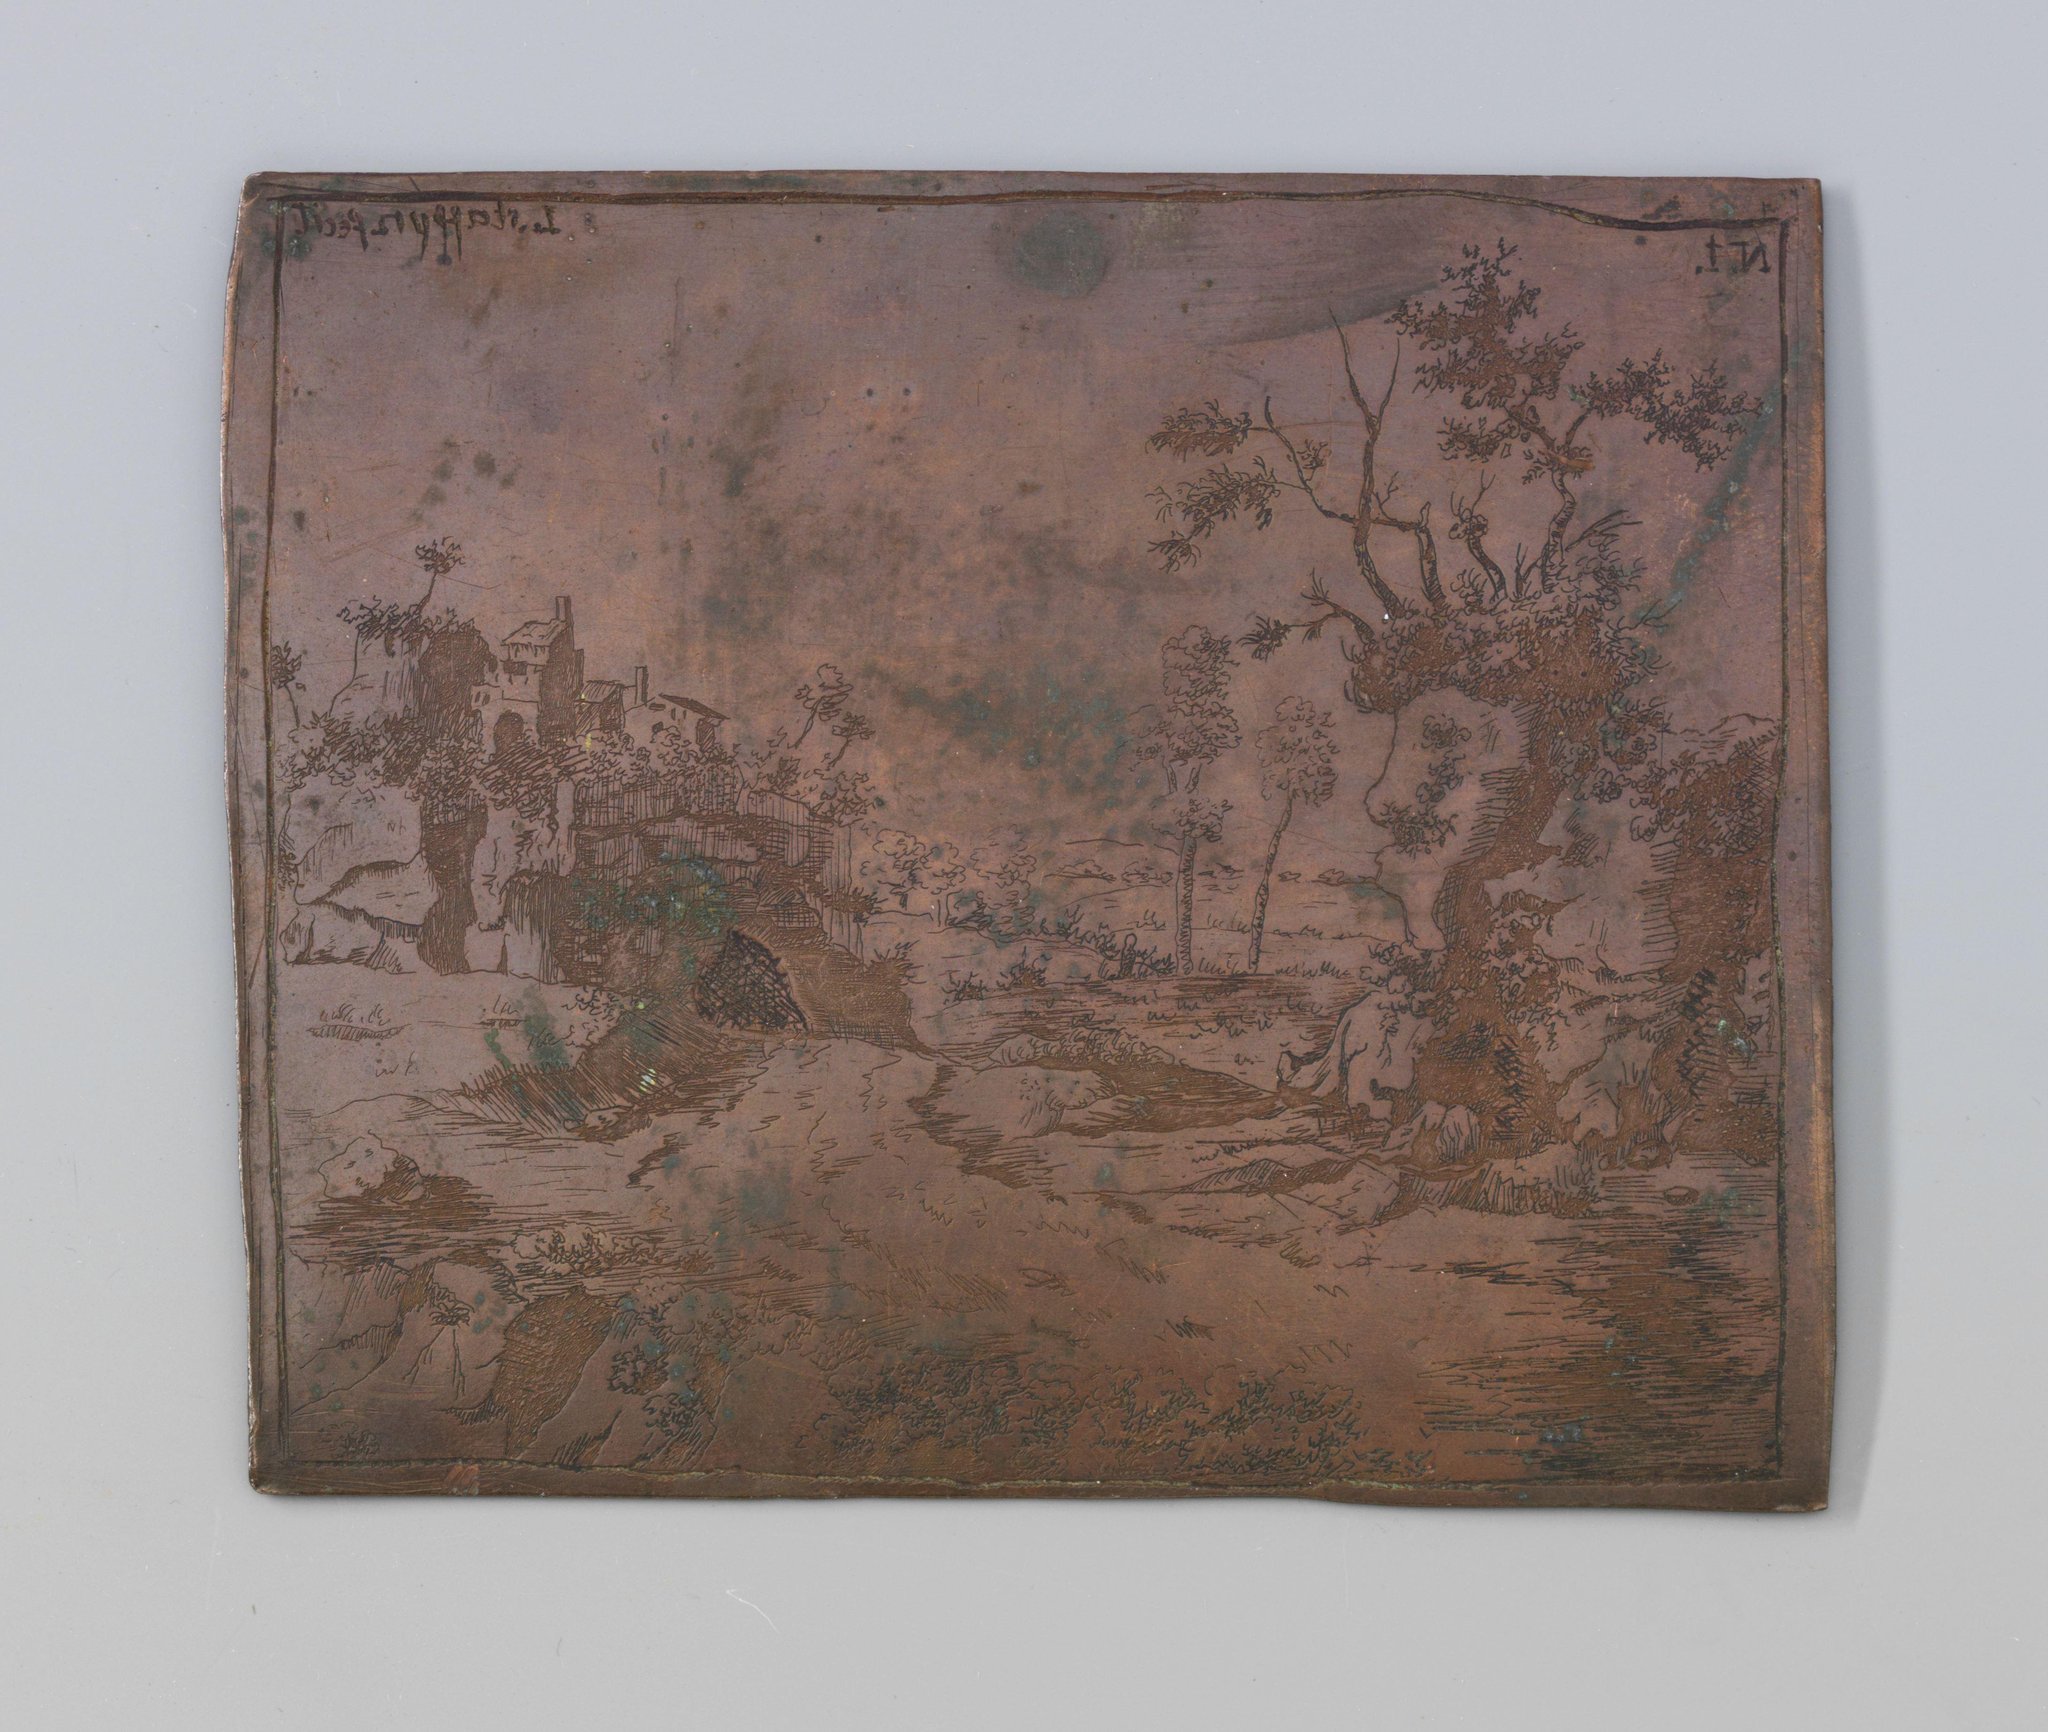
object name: copper plate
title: Rotsachtig landschap met huizen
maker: l. staffijn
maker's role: print maker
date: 1600-1699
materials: copper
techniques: etching